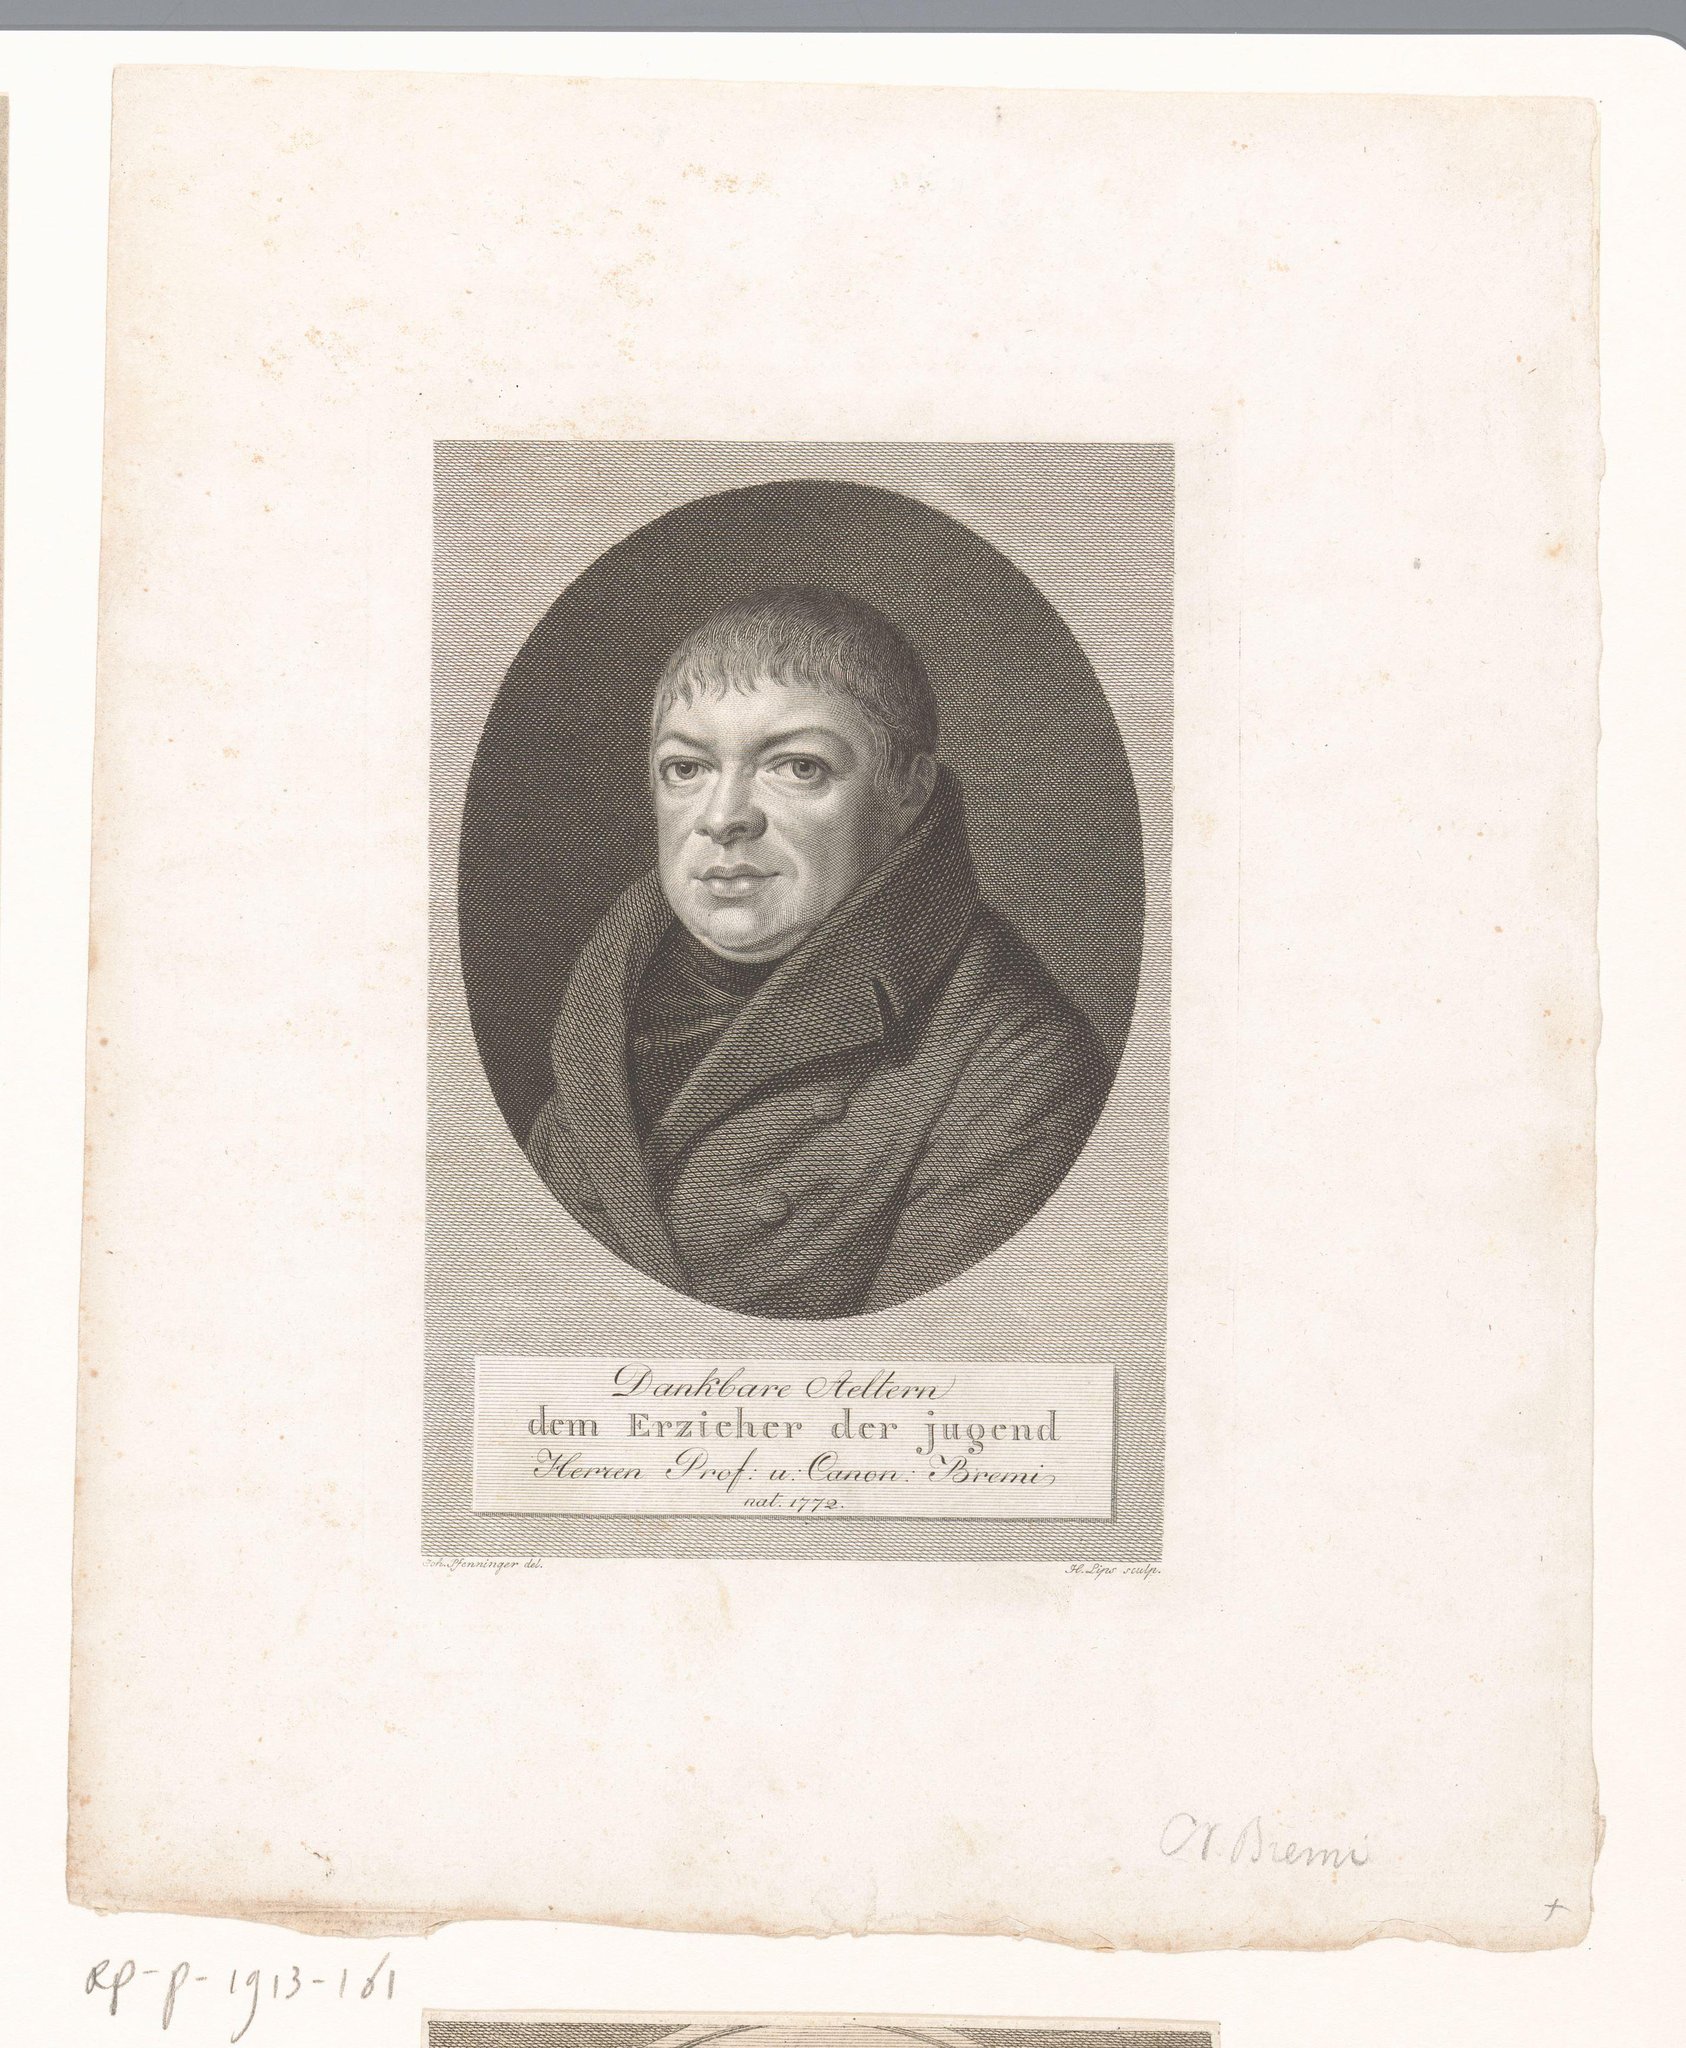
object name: print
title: Portret van Johann Heinrich Bremi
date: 1772-1817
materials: paper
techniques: engraving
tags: historical persons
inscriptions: collector's mark: Lugt 2228